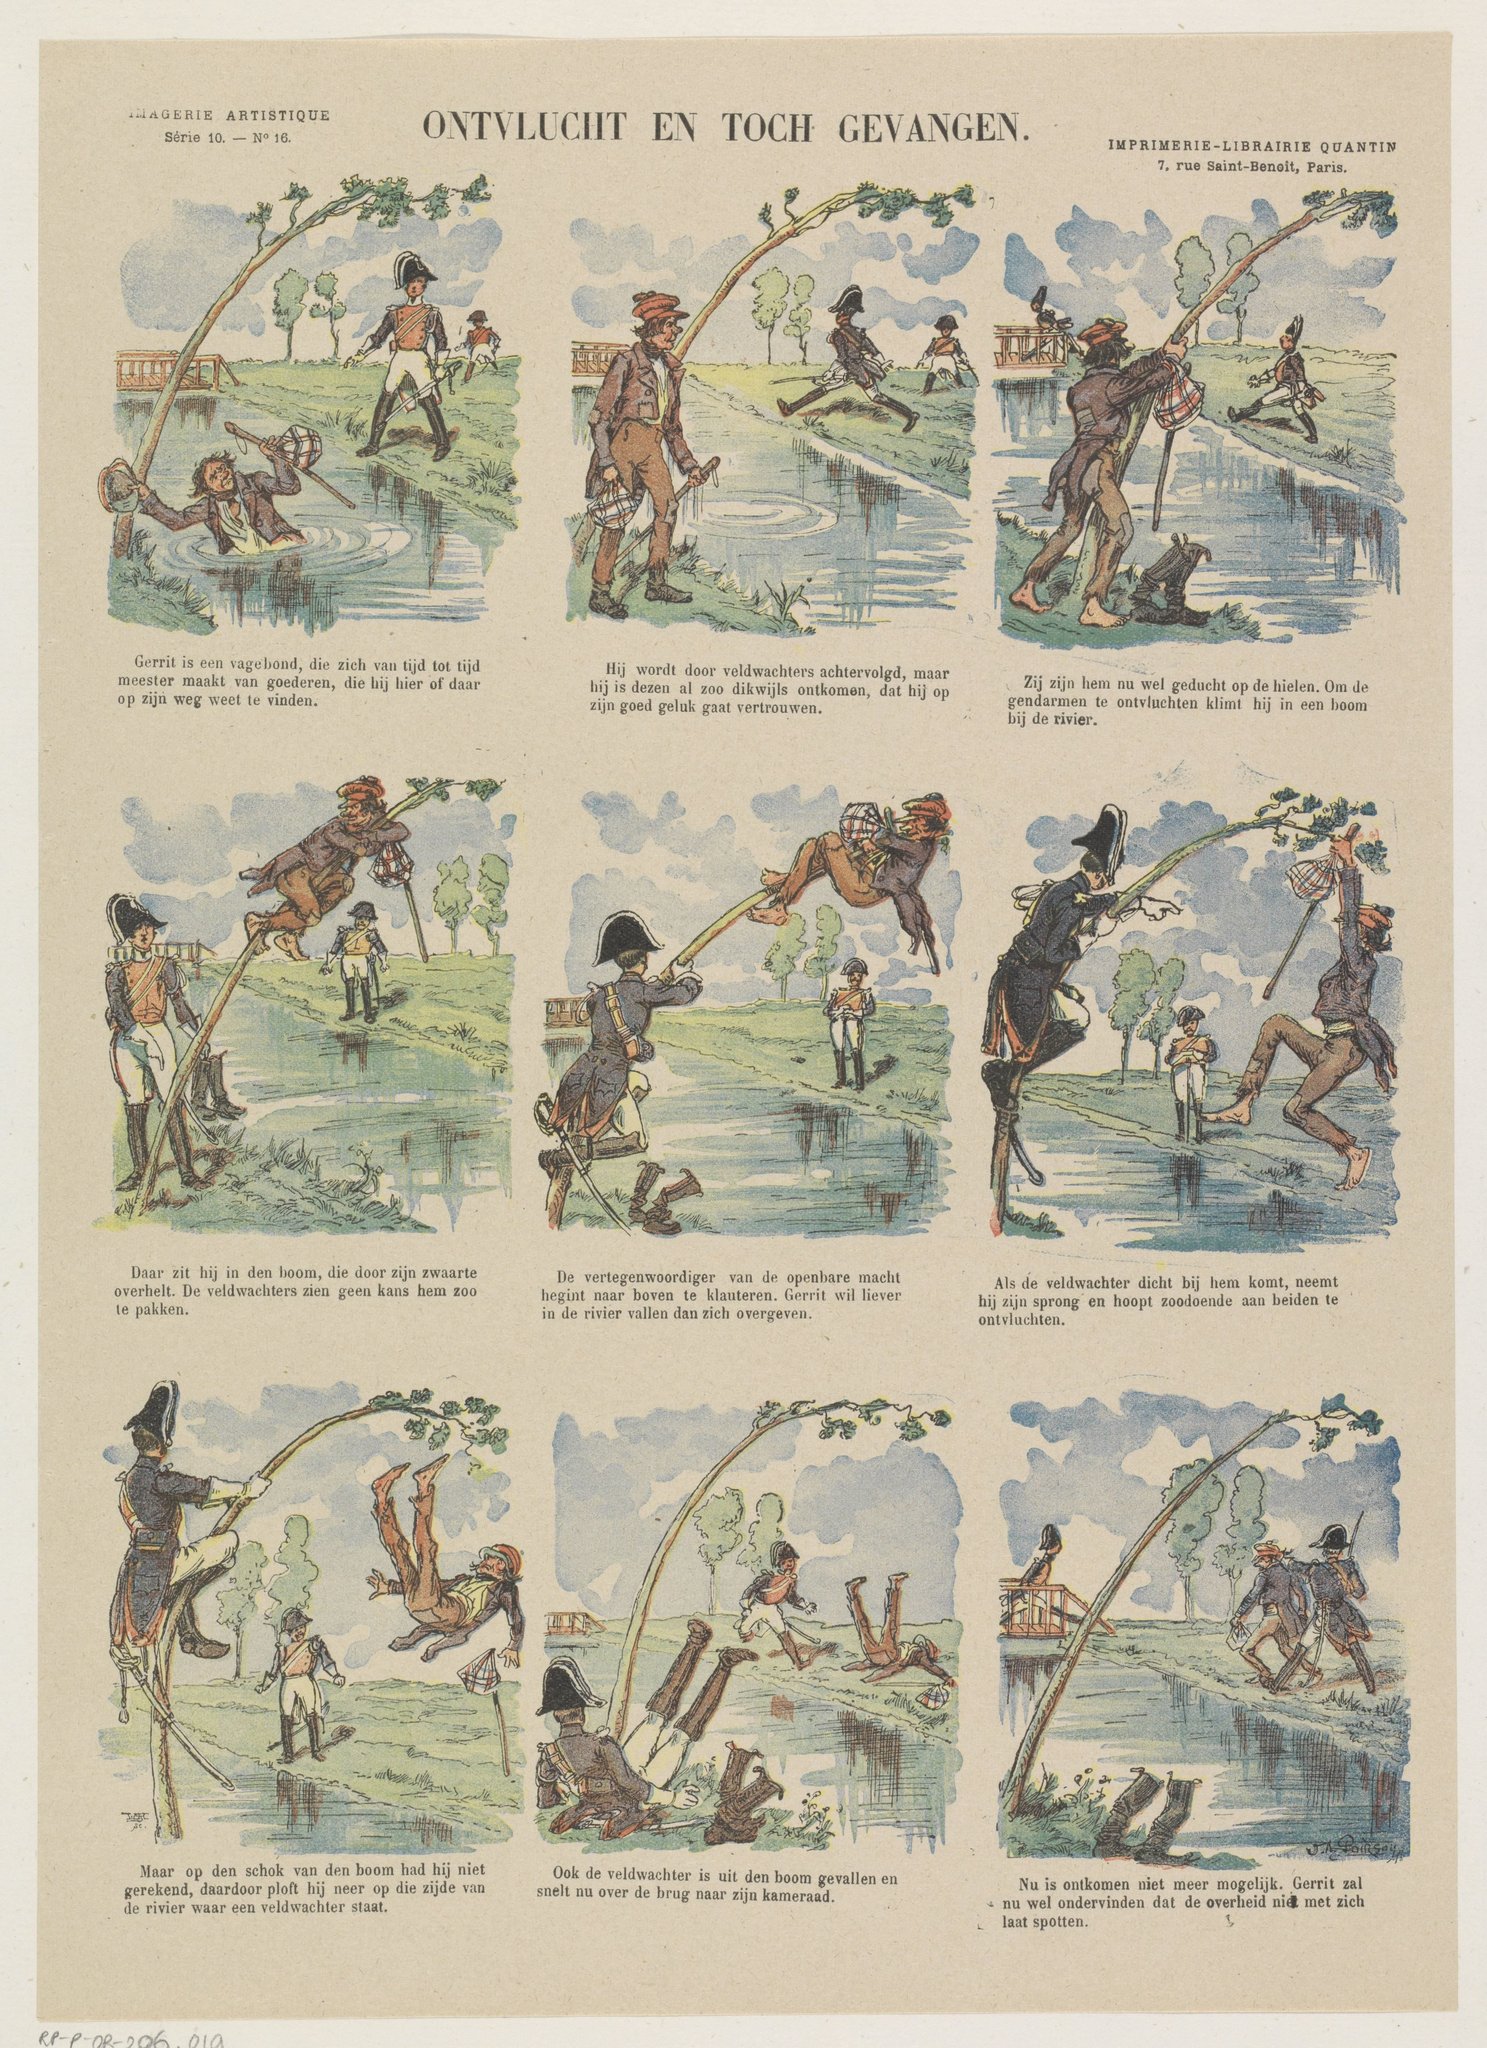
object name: print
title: Imagerie Artistique / Série 10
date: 1876-1890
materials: paper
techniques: lithograph, letterpress printing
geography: paris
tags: 'fahrende leute', vagrants, tales and fairy tales, arrest (of criminal)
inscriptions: collector's mark: Lugt 2760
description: Blad met 9 voorstellingen van zwerver Gerrit die gevangen wordt door veldwachters. Onder elke afbeelding een onderschrift. Genummerd linksboven: Série 10. - No. 16.